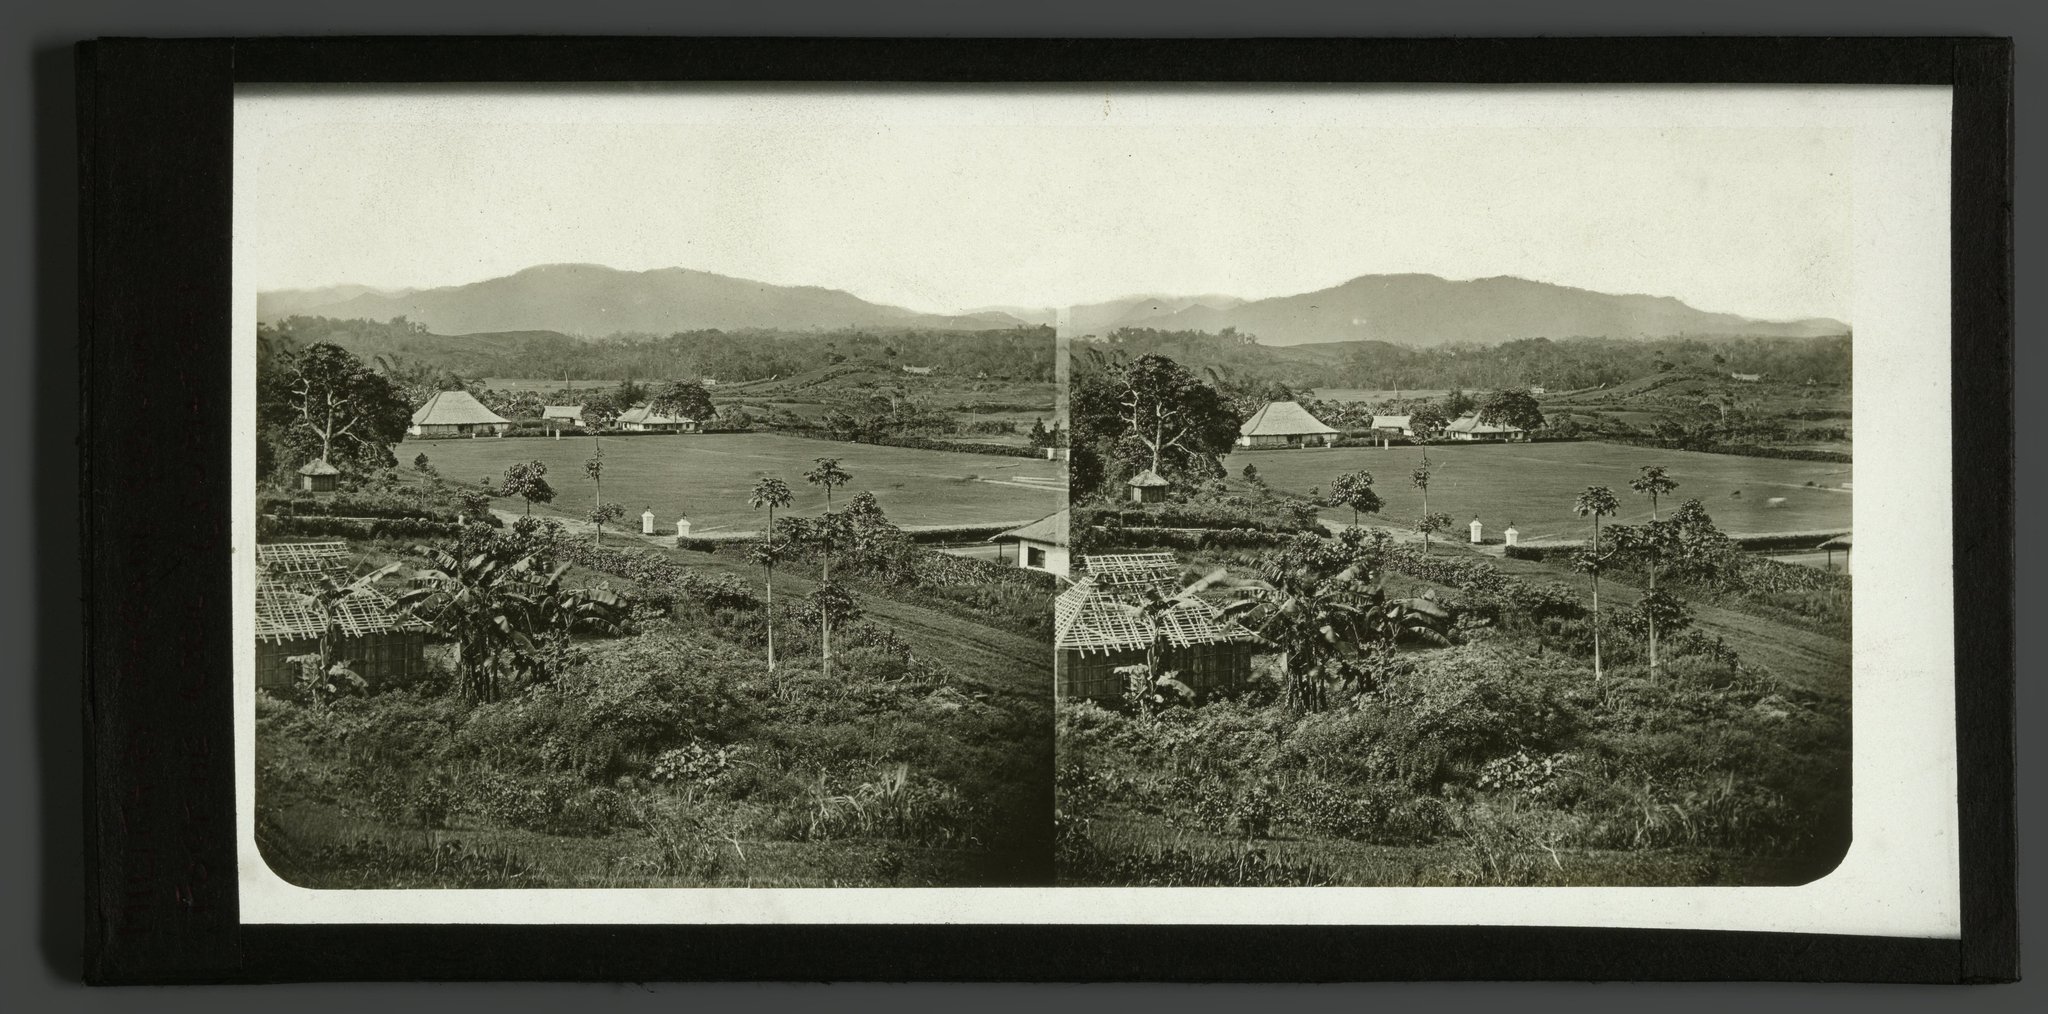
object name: photograph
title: Military parade ground, Fort de Kock (Sumatra)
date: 1857-1864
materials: glass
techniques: slide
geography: bukittinggi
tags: fortress